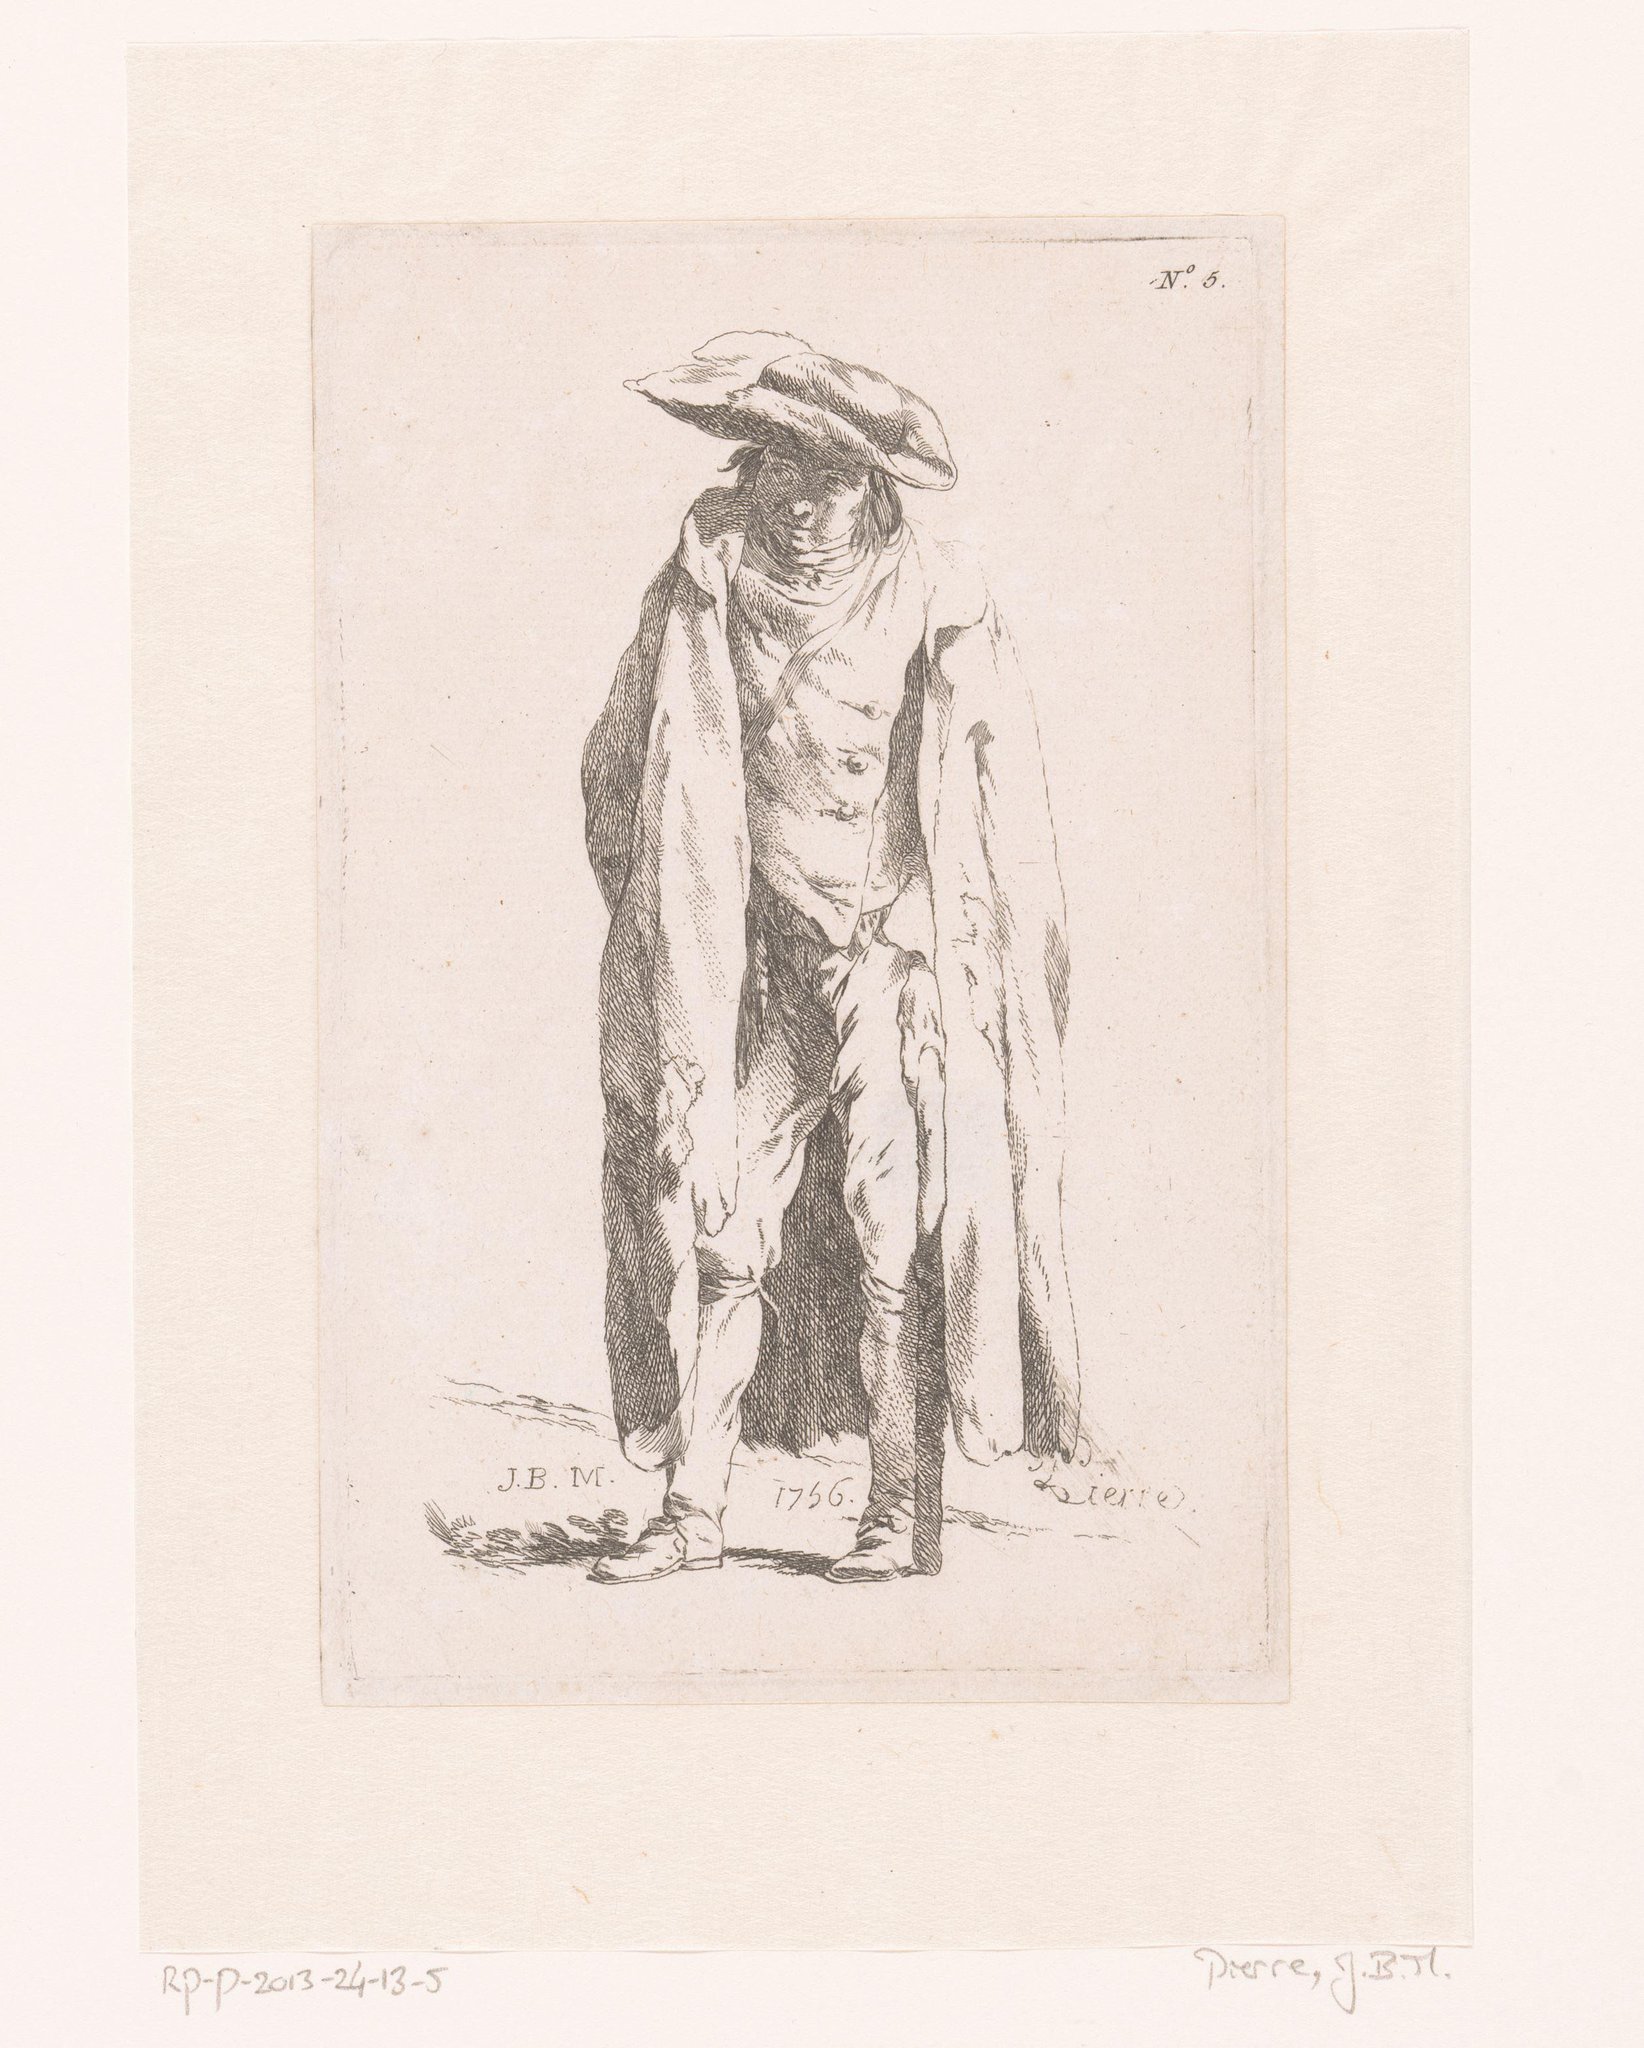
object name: print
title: Man met lange jas en hoed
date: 1756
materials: paper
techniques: etching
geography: paris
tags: coat (+ men's clothes), rome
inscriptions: collector's mark: Lugt 2228, collector's mark: Lugt 5f, collector's mark: Lugt 2760